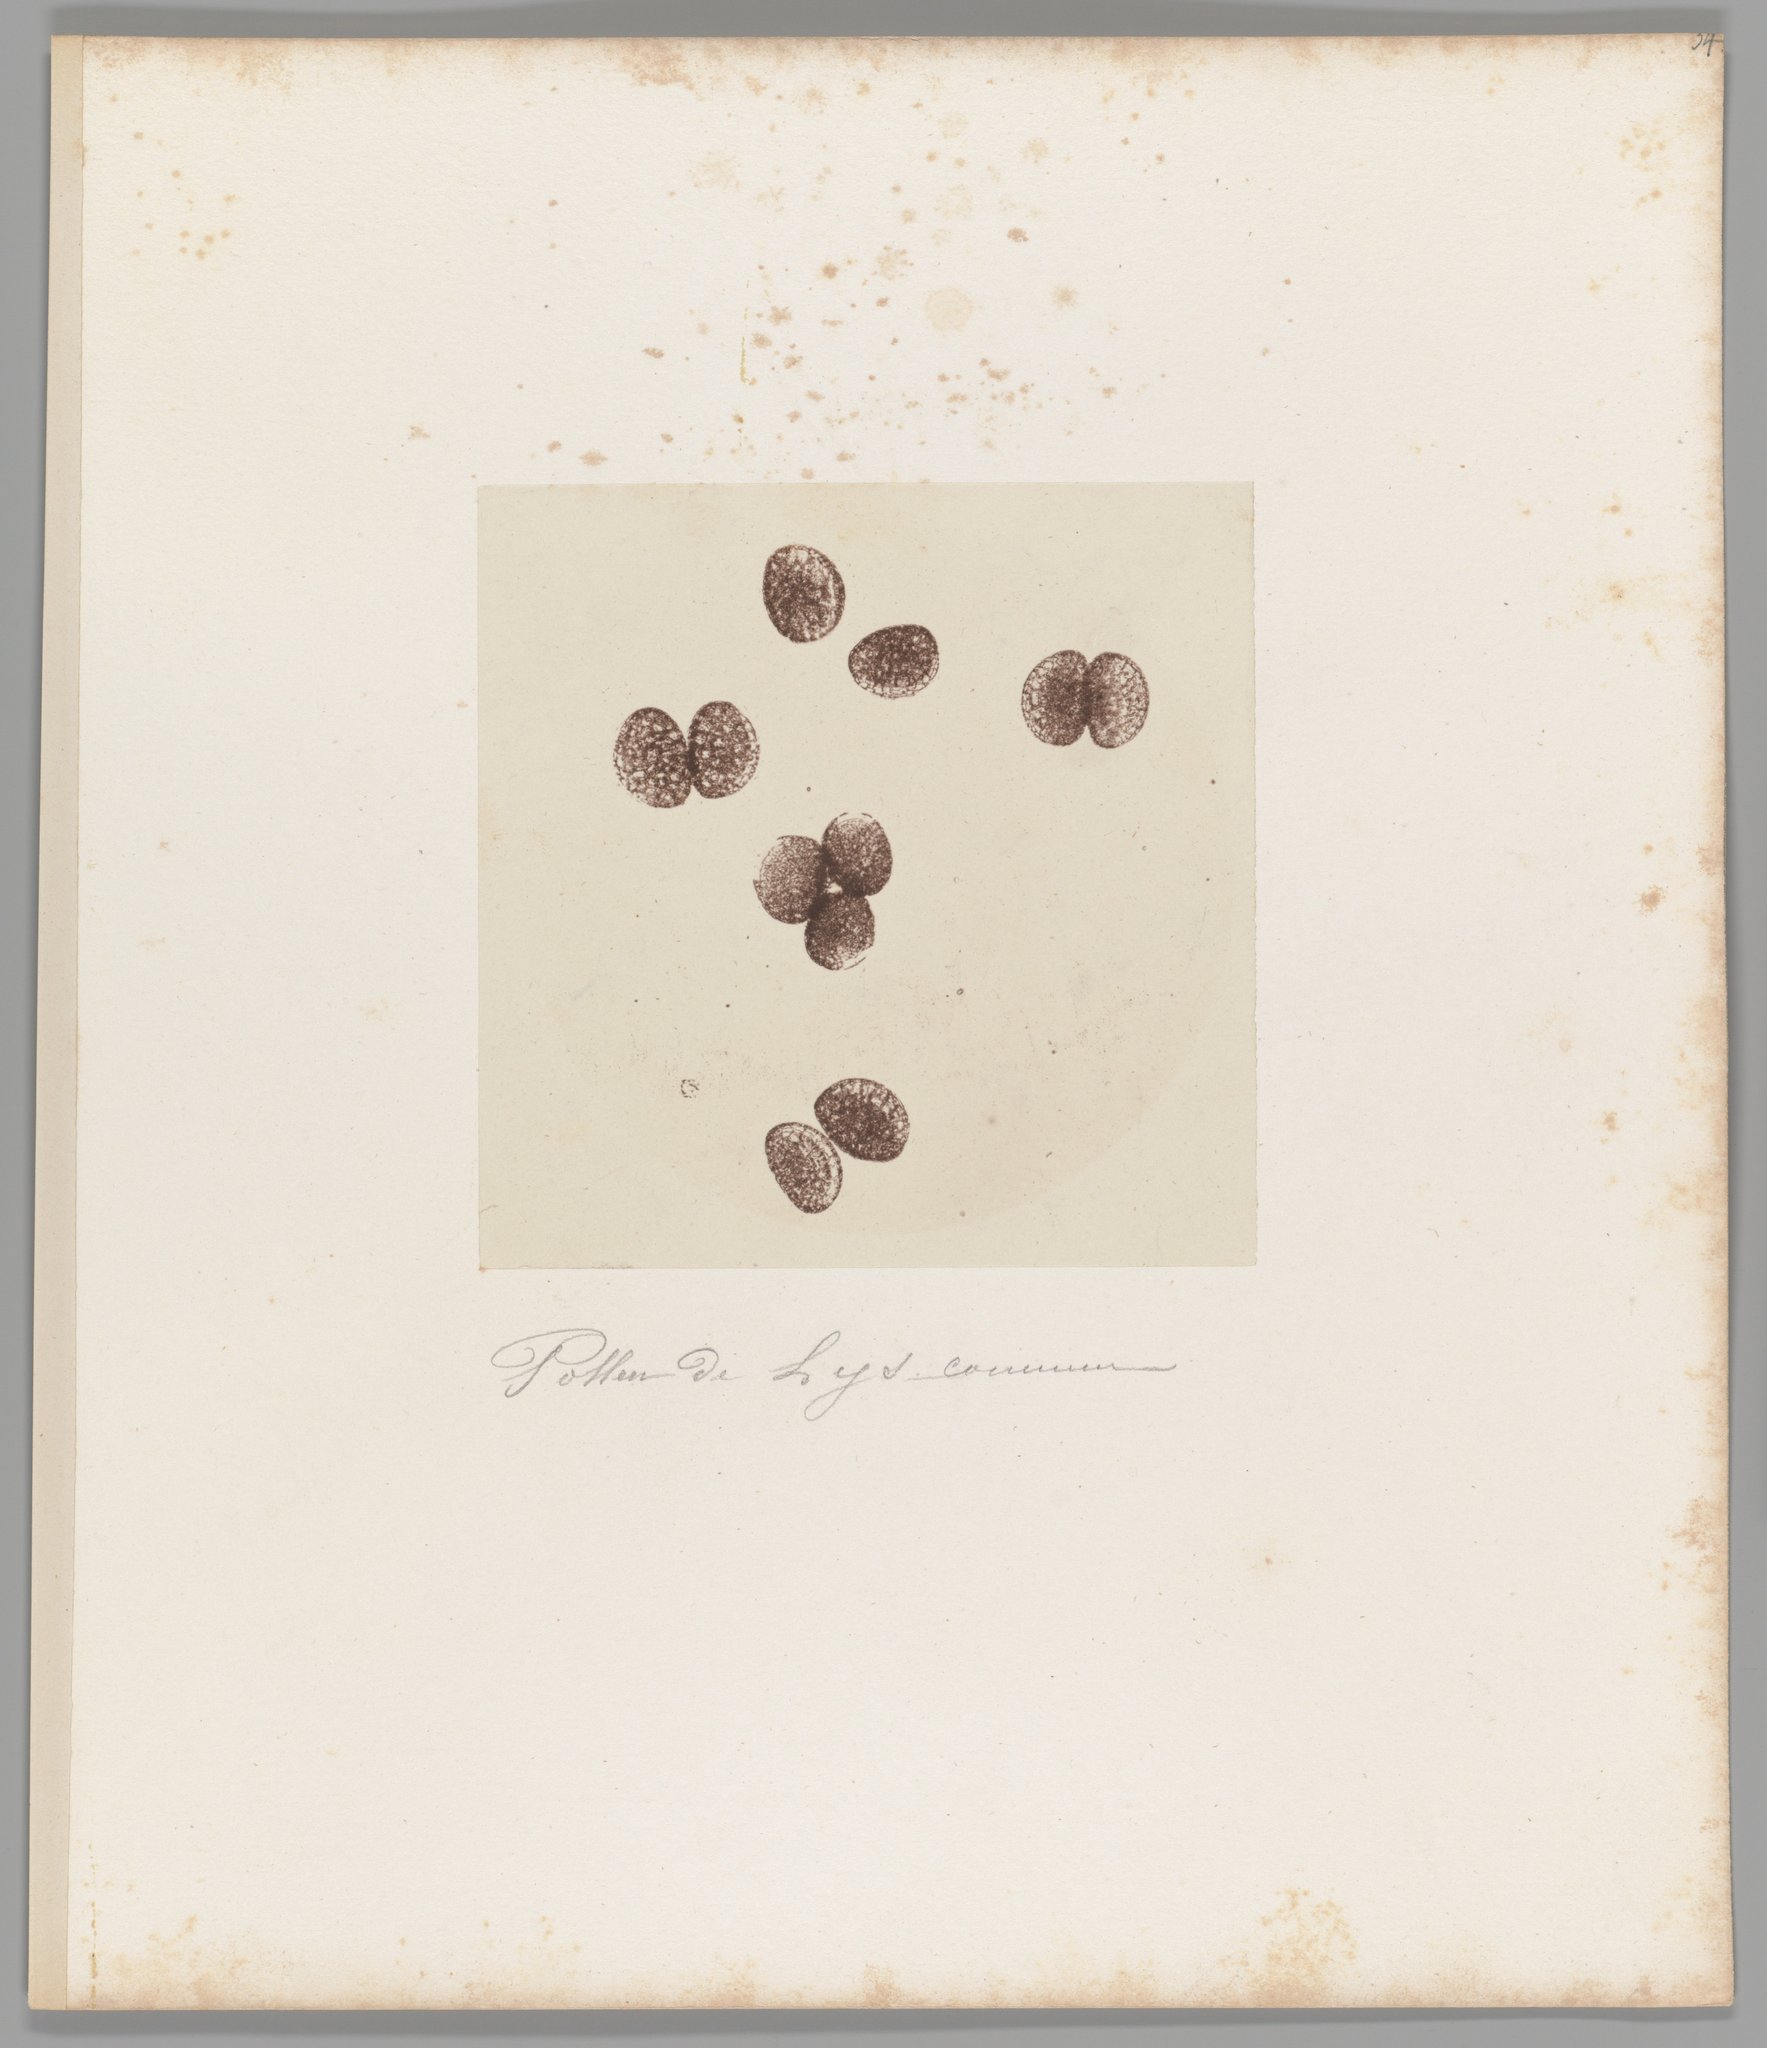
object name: photograph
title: [Untitled]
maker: auguste-adolphe bertsch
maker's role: artist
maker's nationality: french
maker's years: 1813-1871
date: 1853-1857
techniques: salted paper print